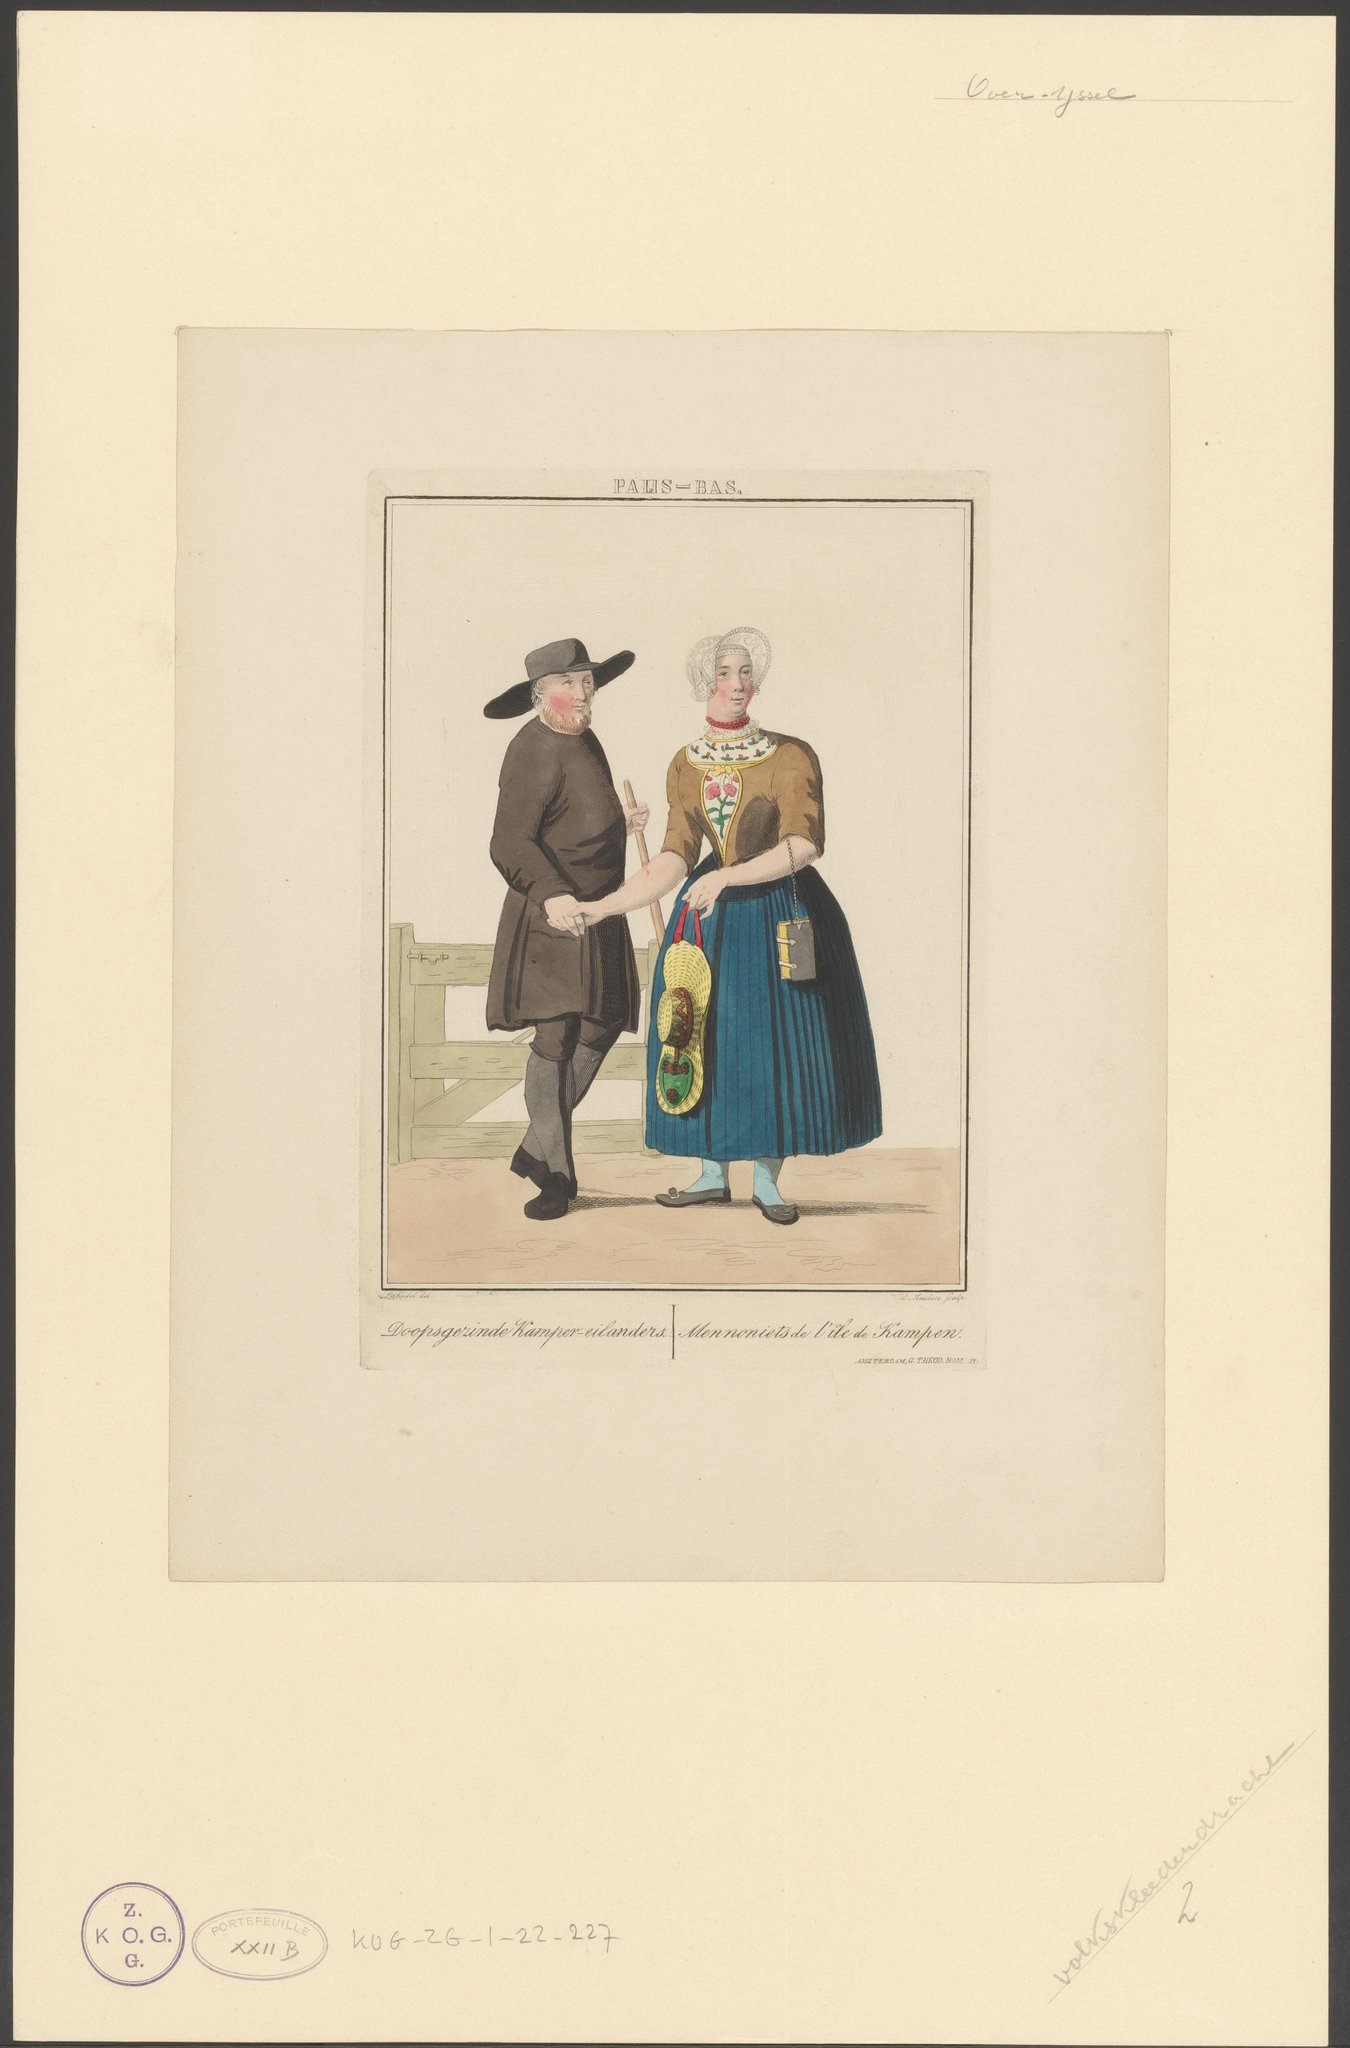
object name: print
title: Paijs-Bas / Doopsgezinde Kamper-Eilanders / Mennonites de l'île de Kampen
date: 1823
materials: paper, watercolor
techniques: etching, hand coloring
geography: amsterdam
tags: going to church, clothes, costume (+ women's clothes), clothes, costume (+ men's clothes), folk costume, regional costume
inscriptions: collector's mark: Lugt 1641, collector's mark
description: Gebruikt als illustratie in een latere editie van de prenten uit: Afbeeldingen van de kleeding, zeden en gewoonten in de Bataafsche Republiek, met den aanvang der negentiende eeuw = Tableaux de l'habillement, des moeurs et des coutumes dans la République Batave, au commencement du dix-neuvième siècle. Amsterdam: G. Theod. Bom [n.d.].